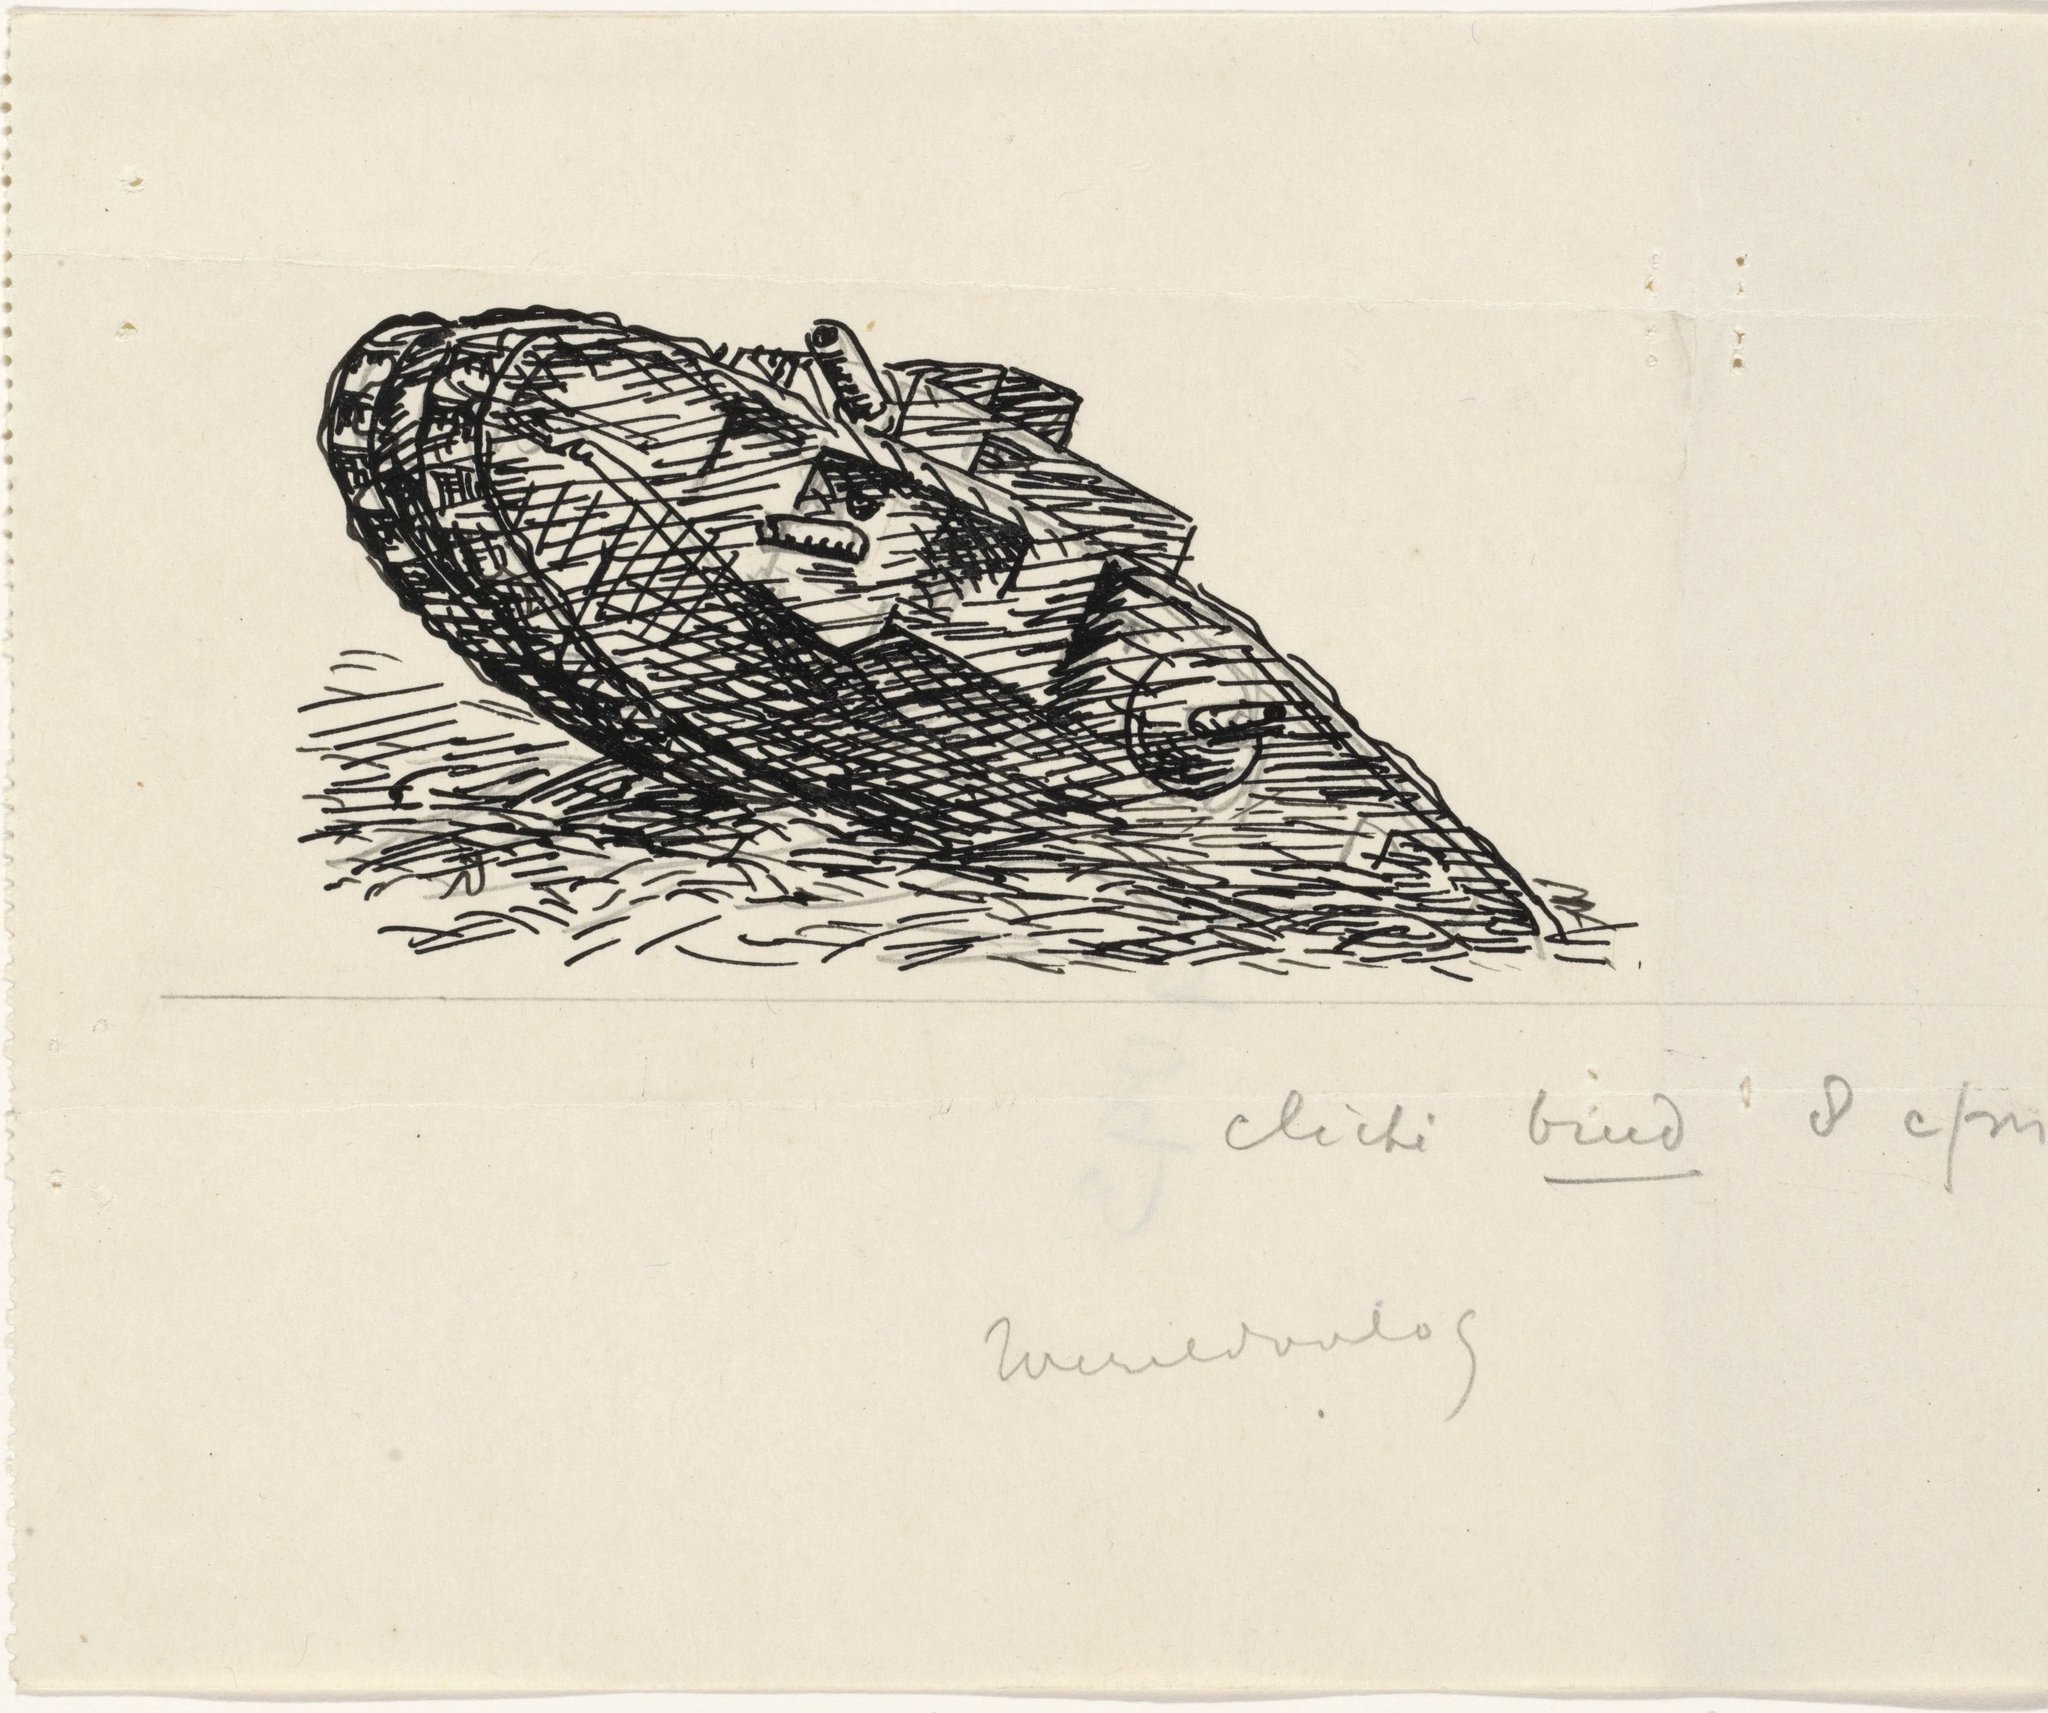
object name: boekillustratie ontwerp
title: Tank rijdt een heuvel op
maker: leo gestel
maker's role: draughtsman, print maker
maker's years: 1881-1941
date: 1934-1936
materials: ink, paper, pencil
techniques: pen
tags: (cohen, van anarchist tot monarchist) specific works of literature (with author, title), modern forms of military vehicles (tank)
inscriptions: clichéaanwijzing, recto, handgeschreven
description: Ontwerp voor een boekillustratie voor: Cohen, Alexander. Van anarchist tot monarchist. Amsterdam: De Steenuil, 1936.